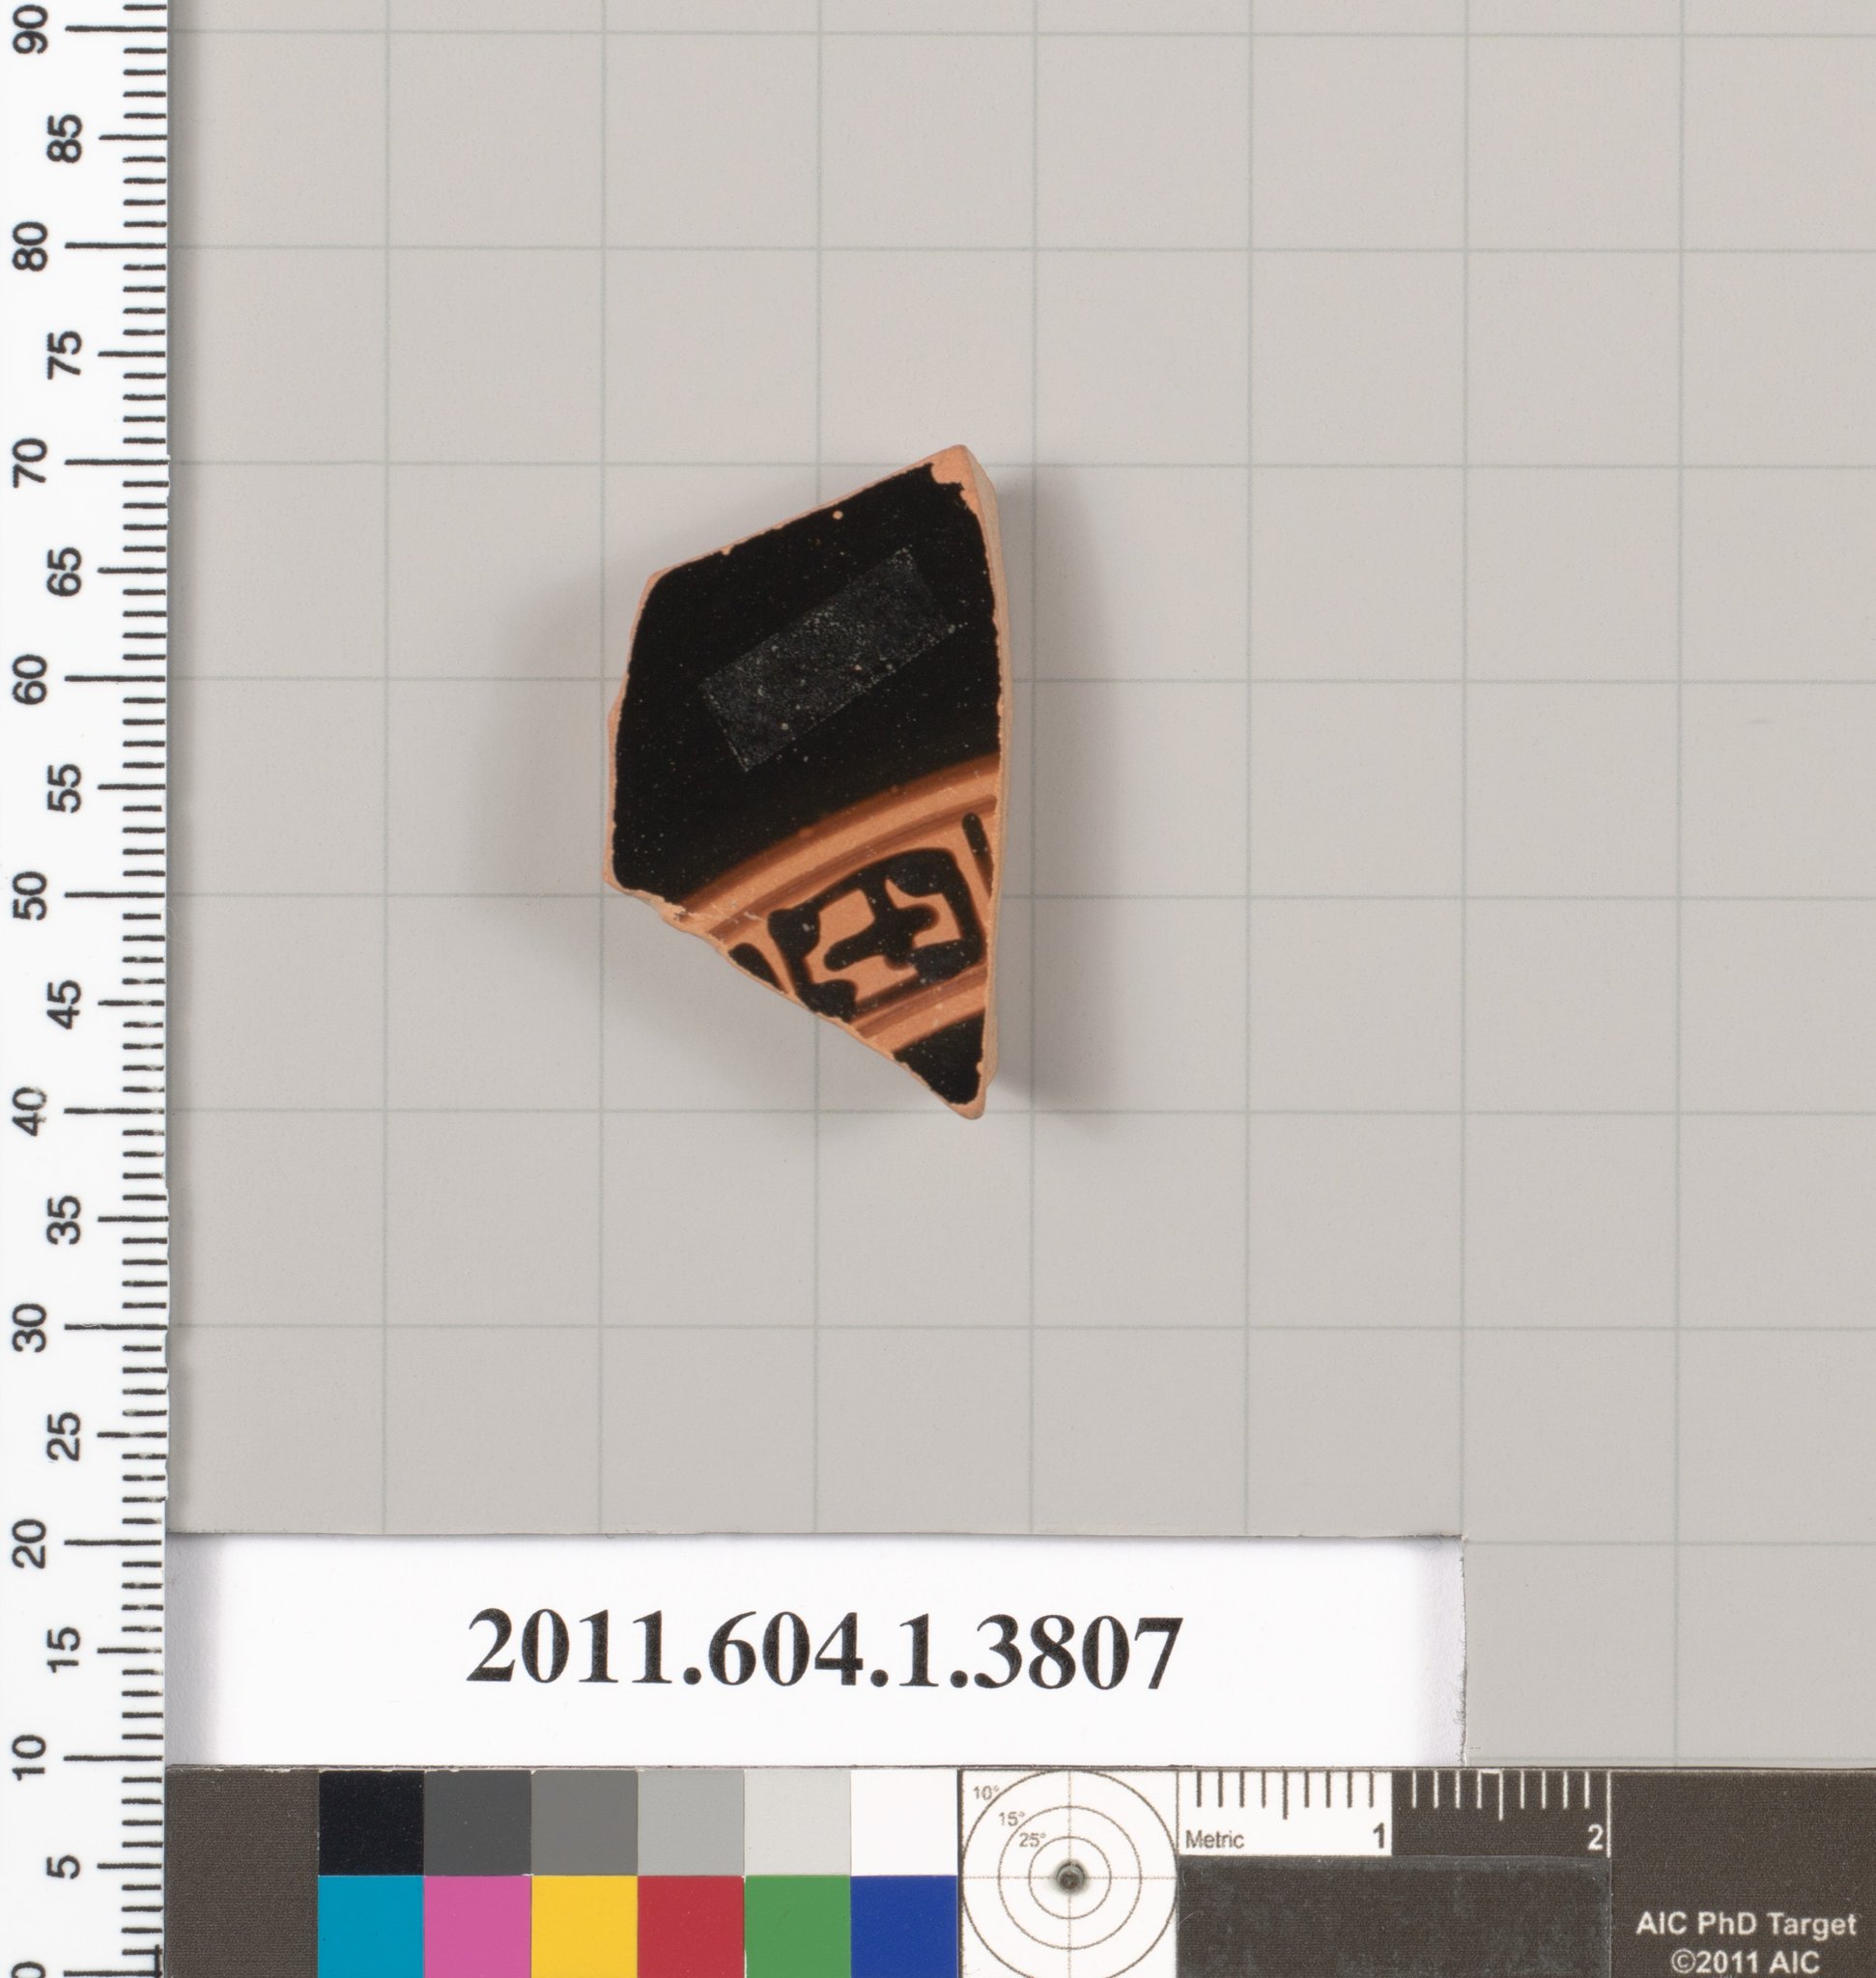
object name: kylix fragment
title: Terracotta fragment of a kylix (drinking cup)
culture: greek, attic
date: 475-451 BCE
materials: terracotta